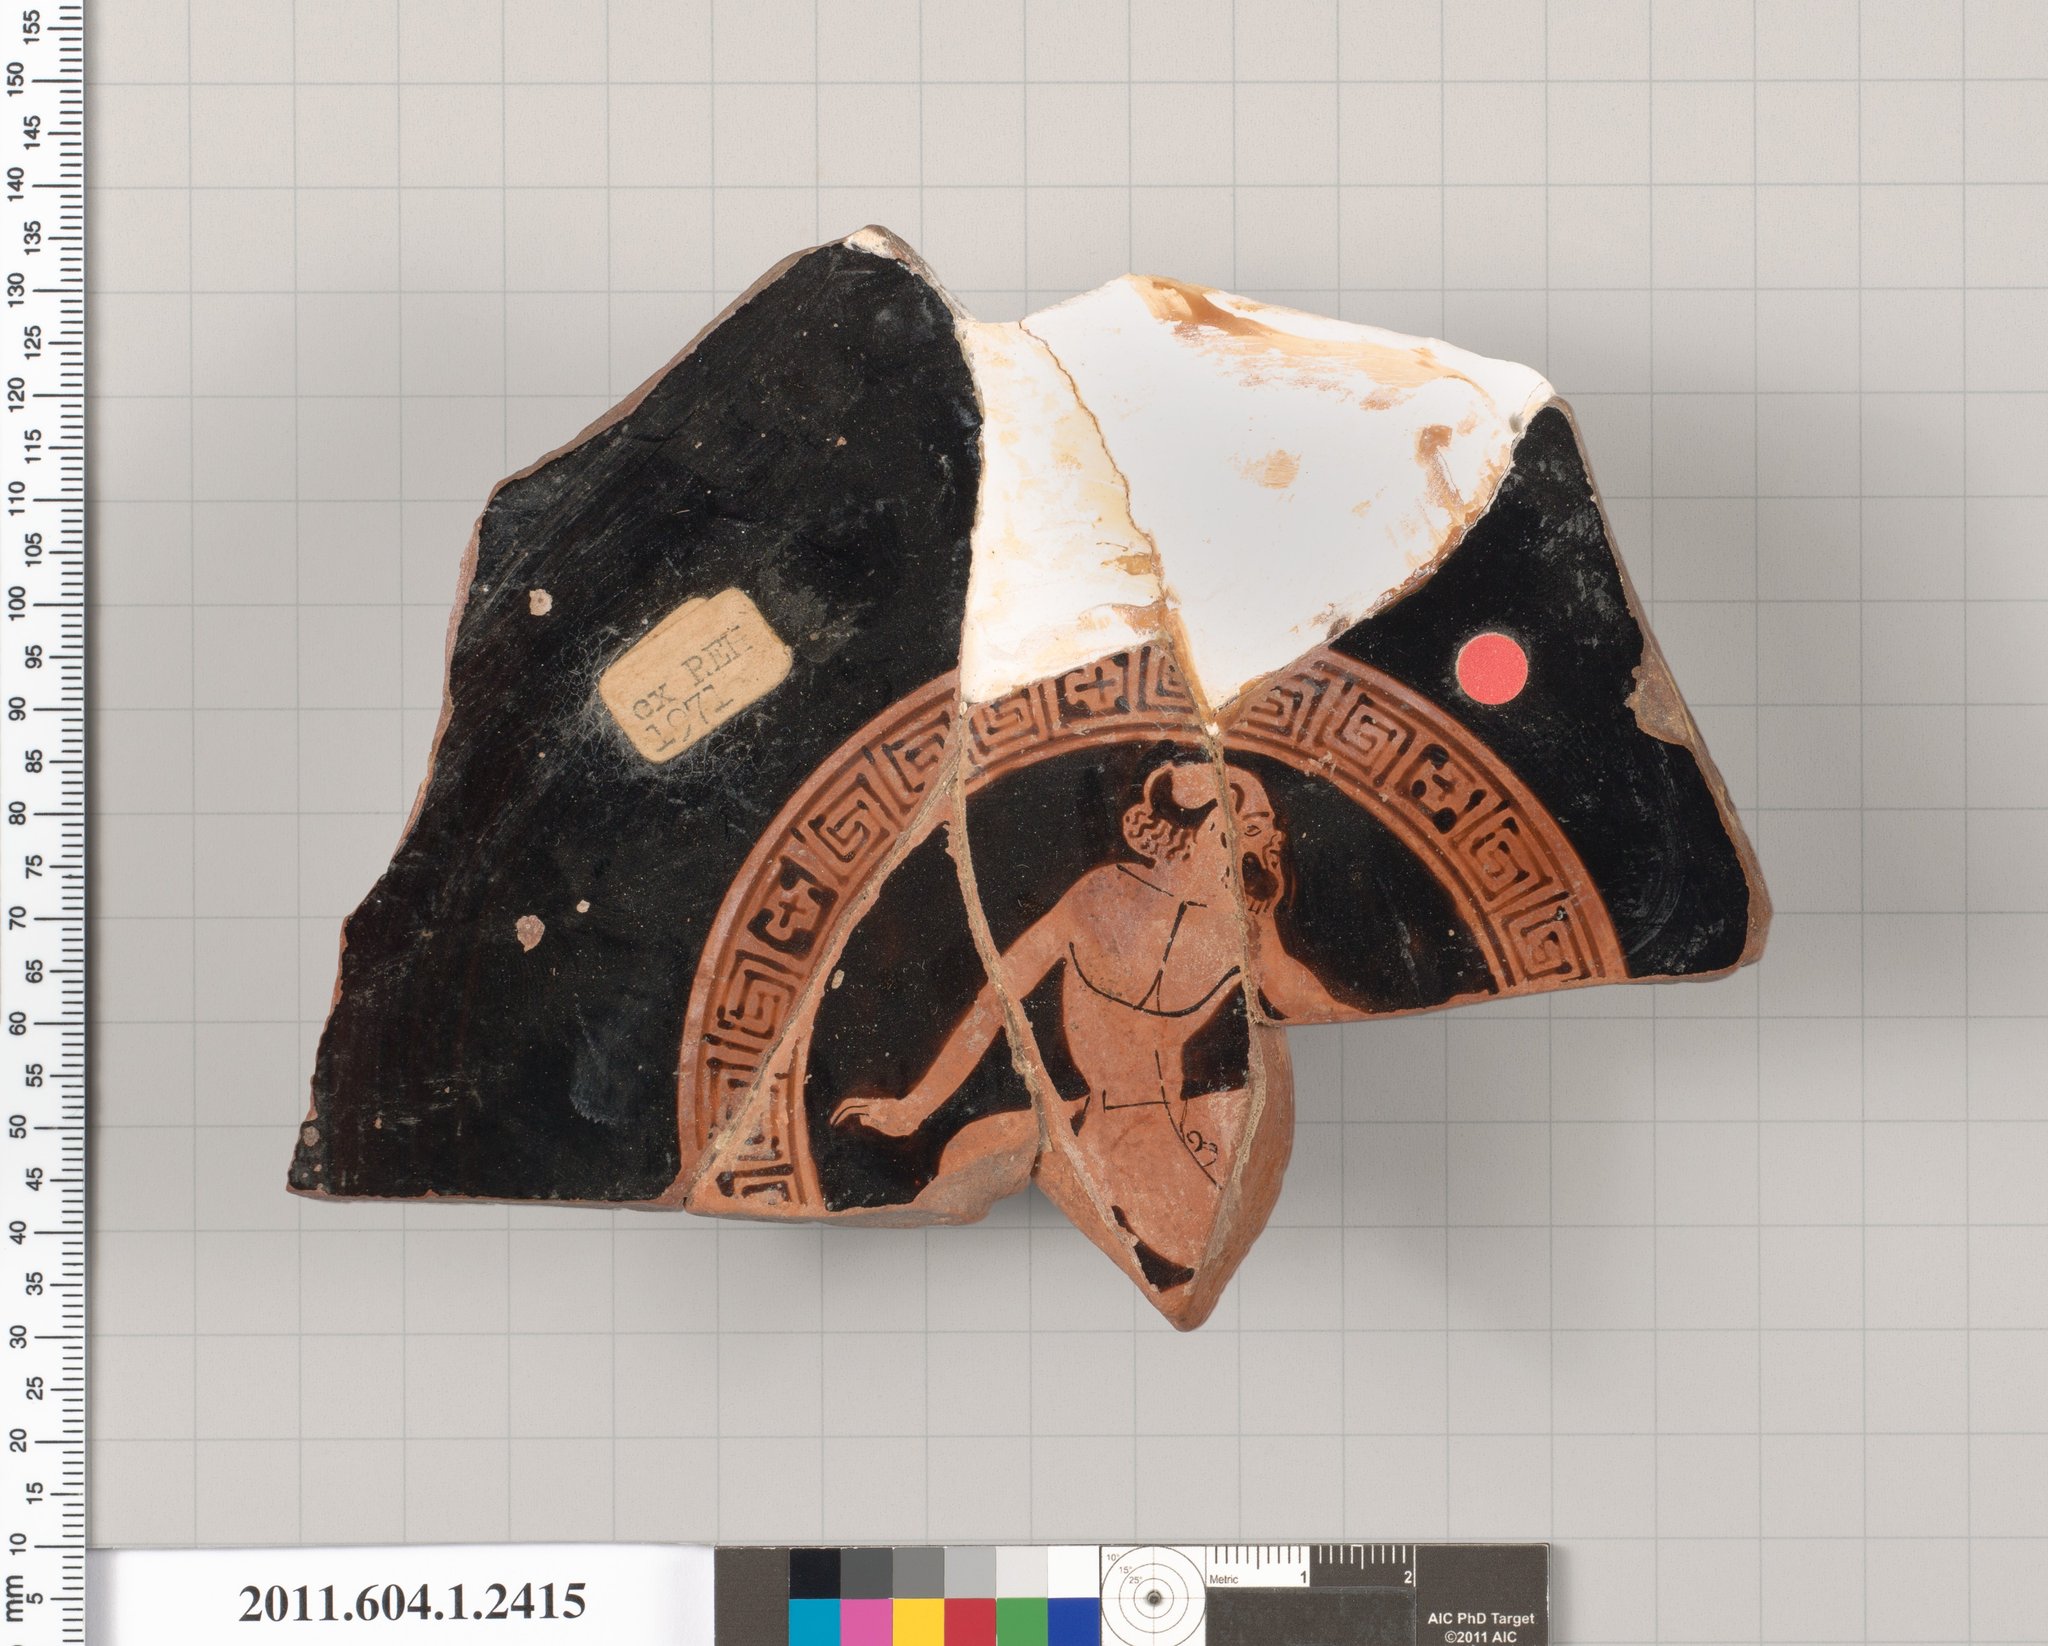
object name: kylix fragment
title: Terracotta fragment of a kylix (drinking cup)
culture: greek, attic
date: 470-460 BCE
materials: terracotta